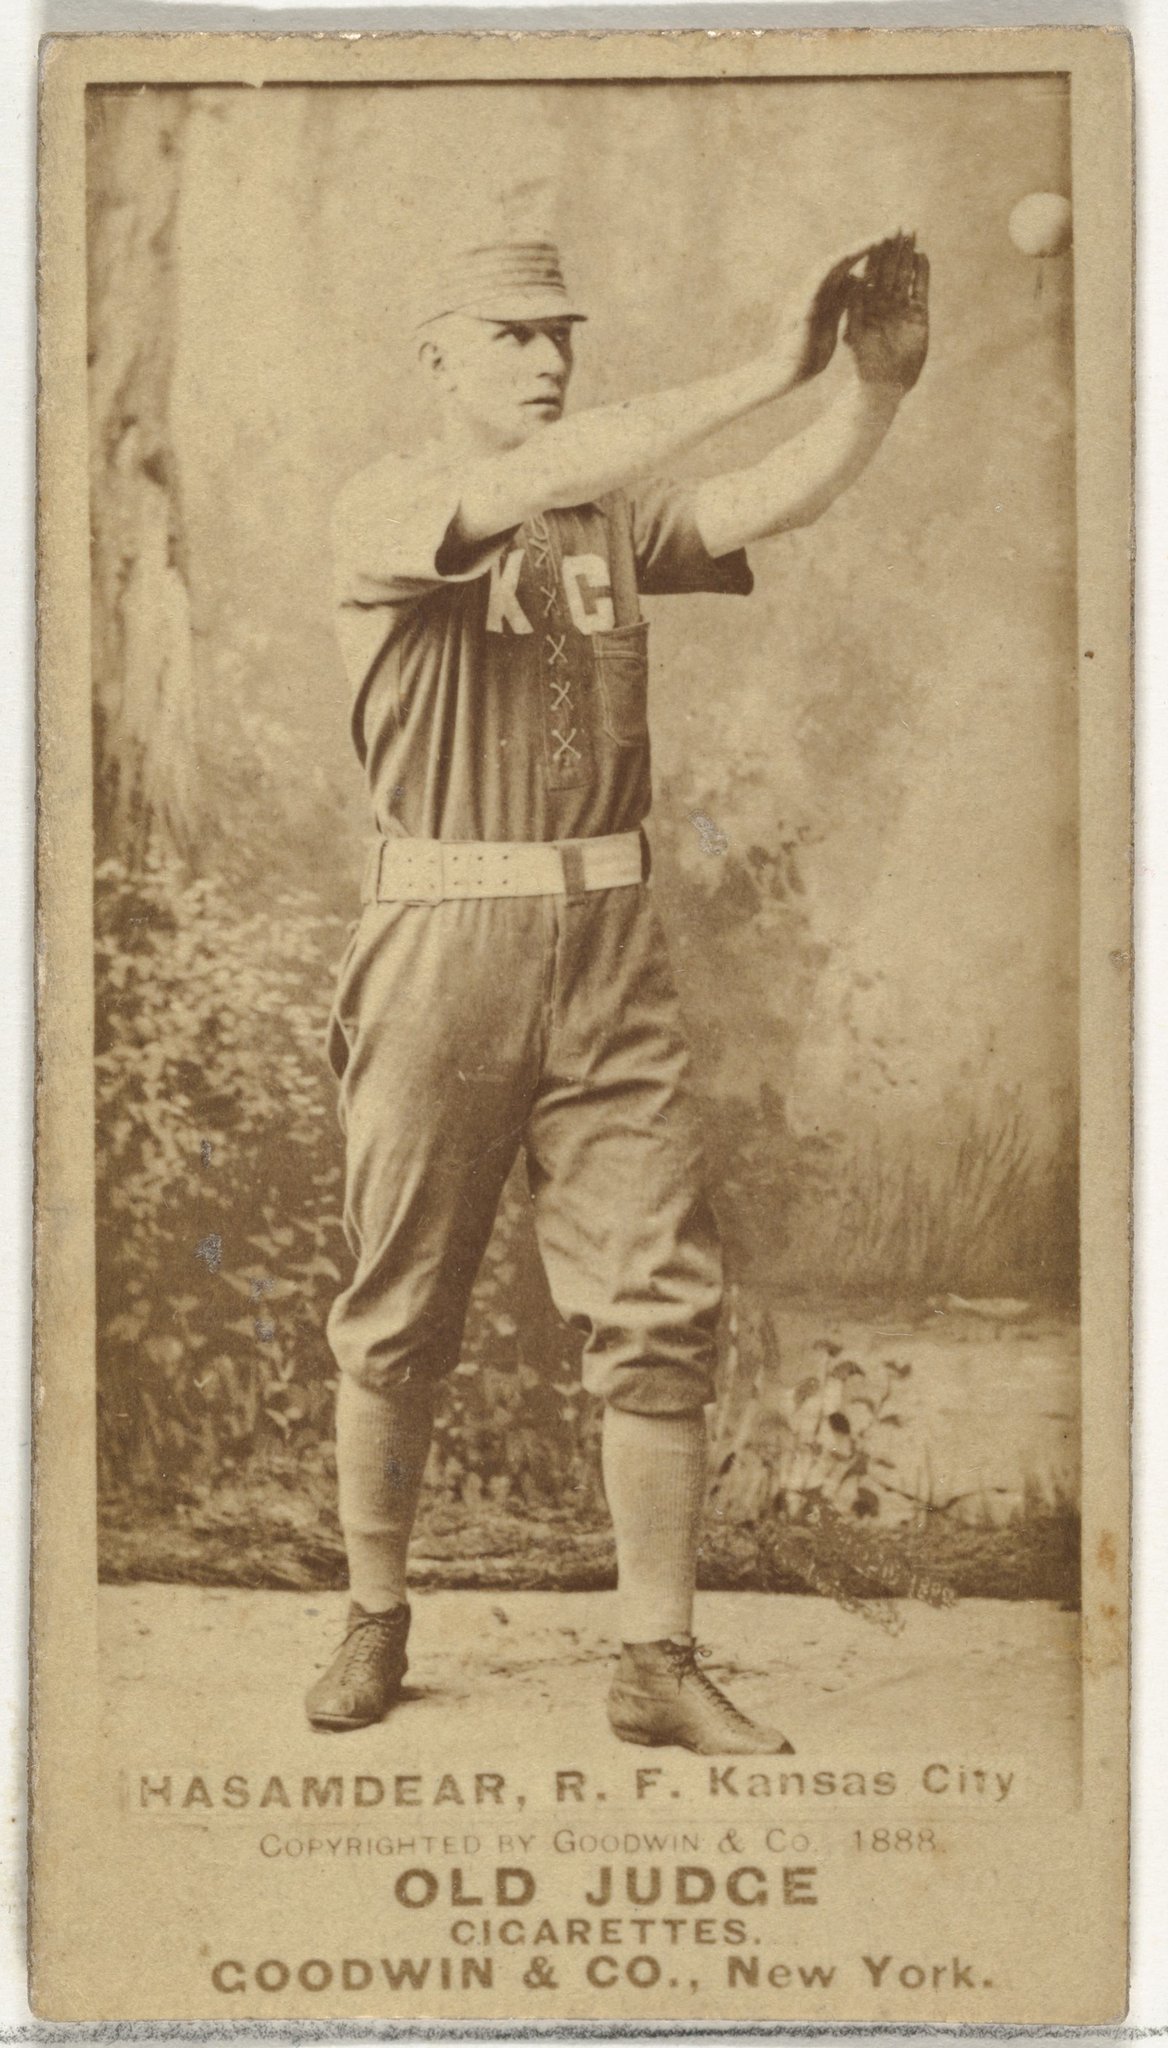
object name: baseball card, photograph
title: William Louis Hassamaer, Right Field, Kansas City Cowboys, from the Old Judge series (N172) for Old Judge Cigarettes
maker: goodwin & company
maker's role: publisher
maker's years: 1850-1950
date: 1889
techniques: albumen silver print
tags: men,portraits,baseball,athletes